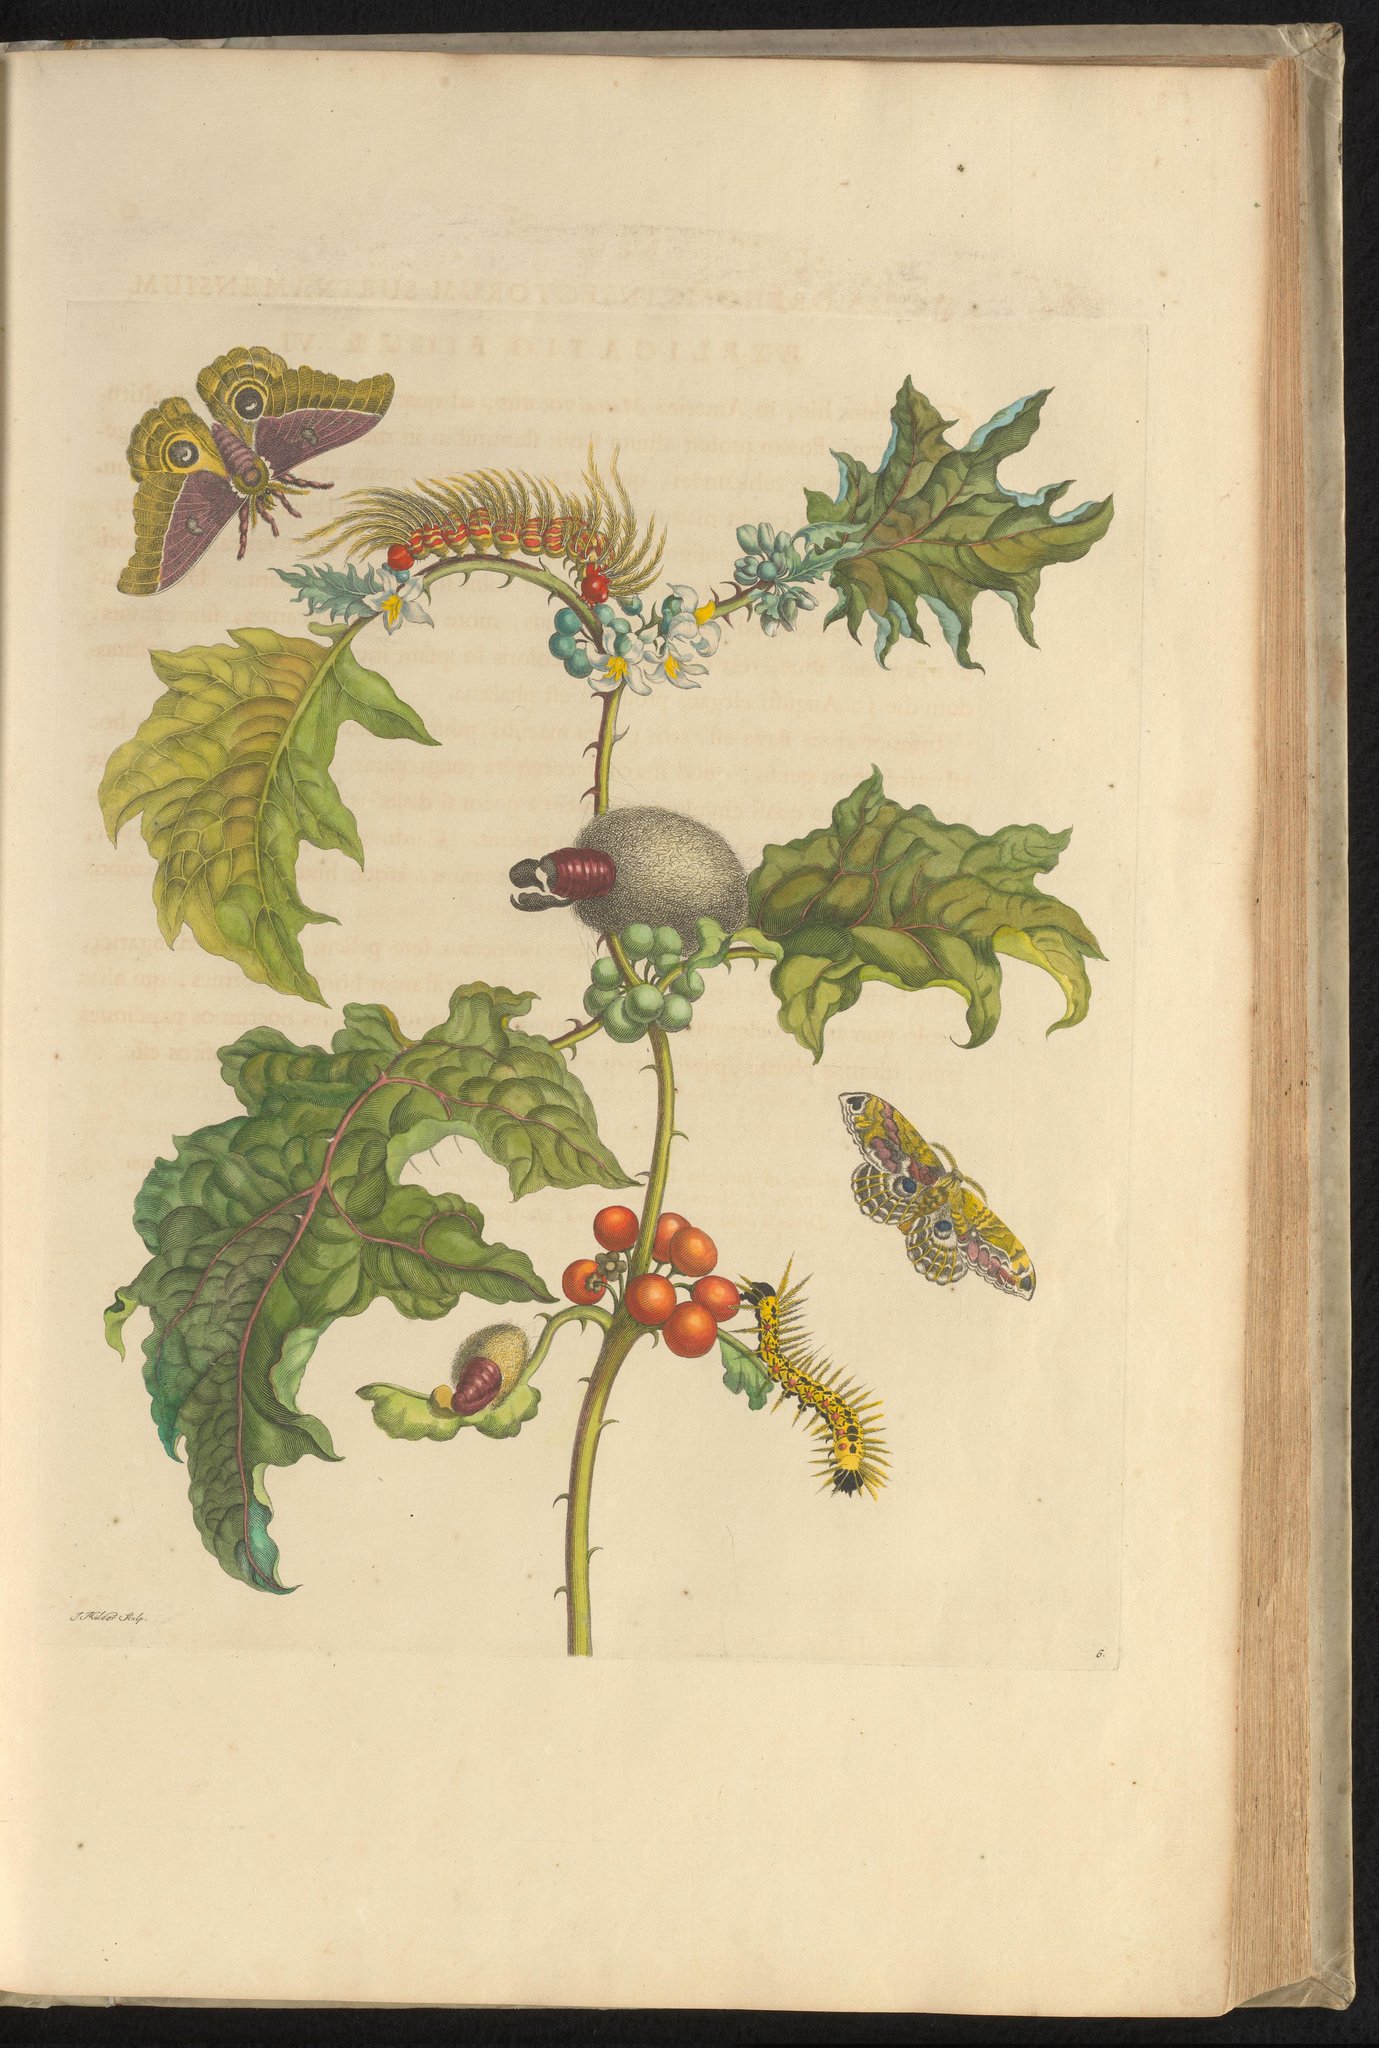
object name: print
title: Bostomaat (Solanum stramoniifolium) met vlinders, rupsen en poppen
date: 1705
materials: paper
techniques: etching, hand coloring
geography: suriname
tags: insects: pupa, insects: butterfly, insects: caterpillar, plants and herbs, suriname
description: Rechtsonder genummerd: 6. Prent maakt deel uit van een boek.